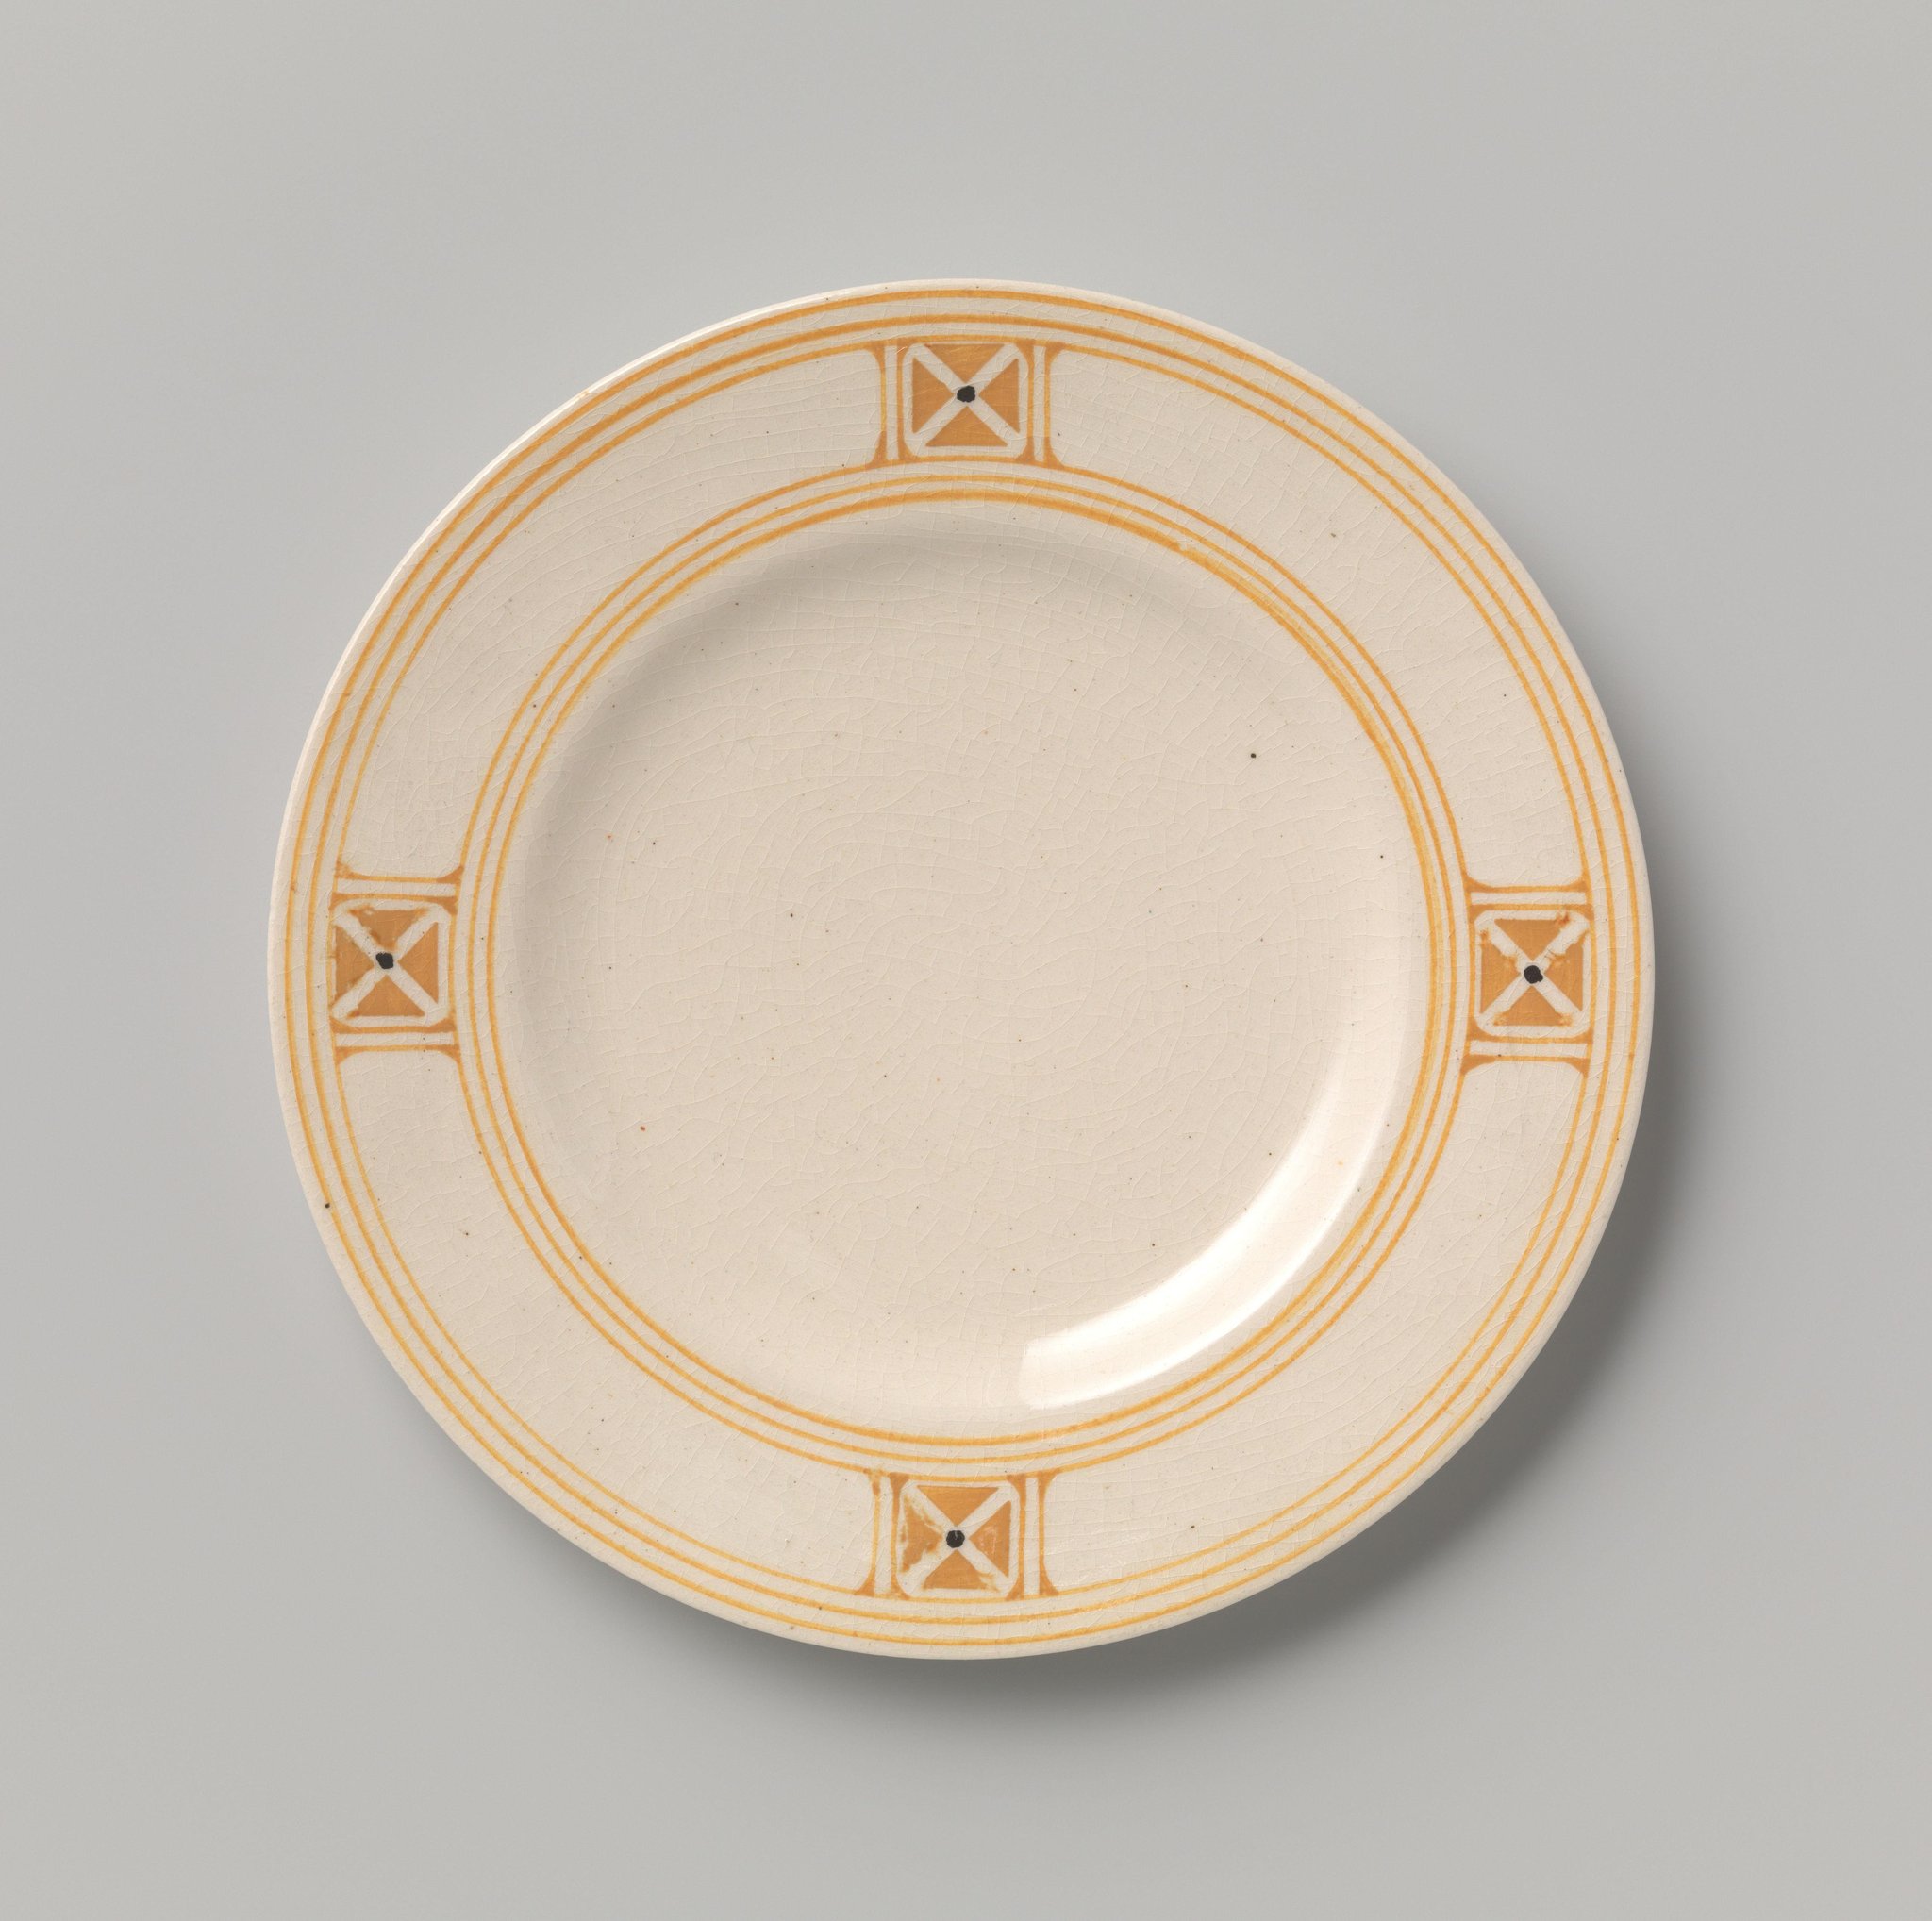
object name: platter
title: Gebakschotel versierd met blokmotief en stippen in geel en zwart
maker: chris van der hoef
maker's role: ceramicist, draughtsman, sculptor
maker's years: 1875-1933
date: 1900-1925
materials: earthenware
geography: netherlands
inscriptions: mark: ‘Amphora Holland ontw. C.J. v d Hoef 268A// horizontale streep 1 J.d V.’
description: Gebakschotel van aardewerk. De randen van de schotel zijn versierd met een blokmotief met stippen in geel en zwart tussen aan weerszijden drie gele biezen.